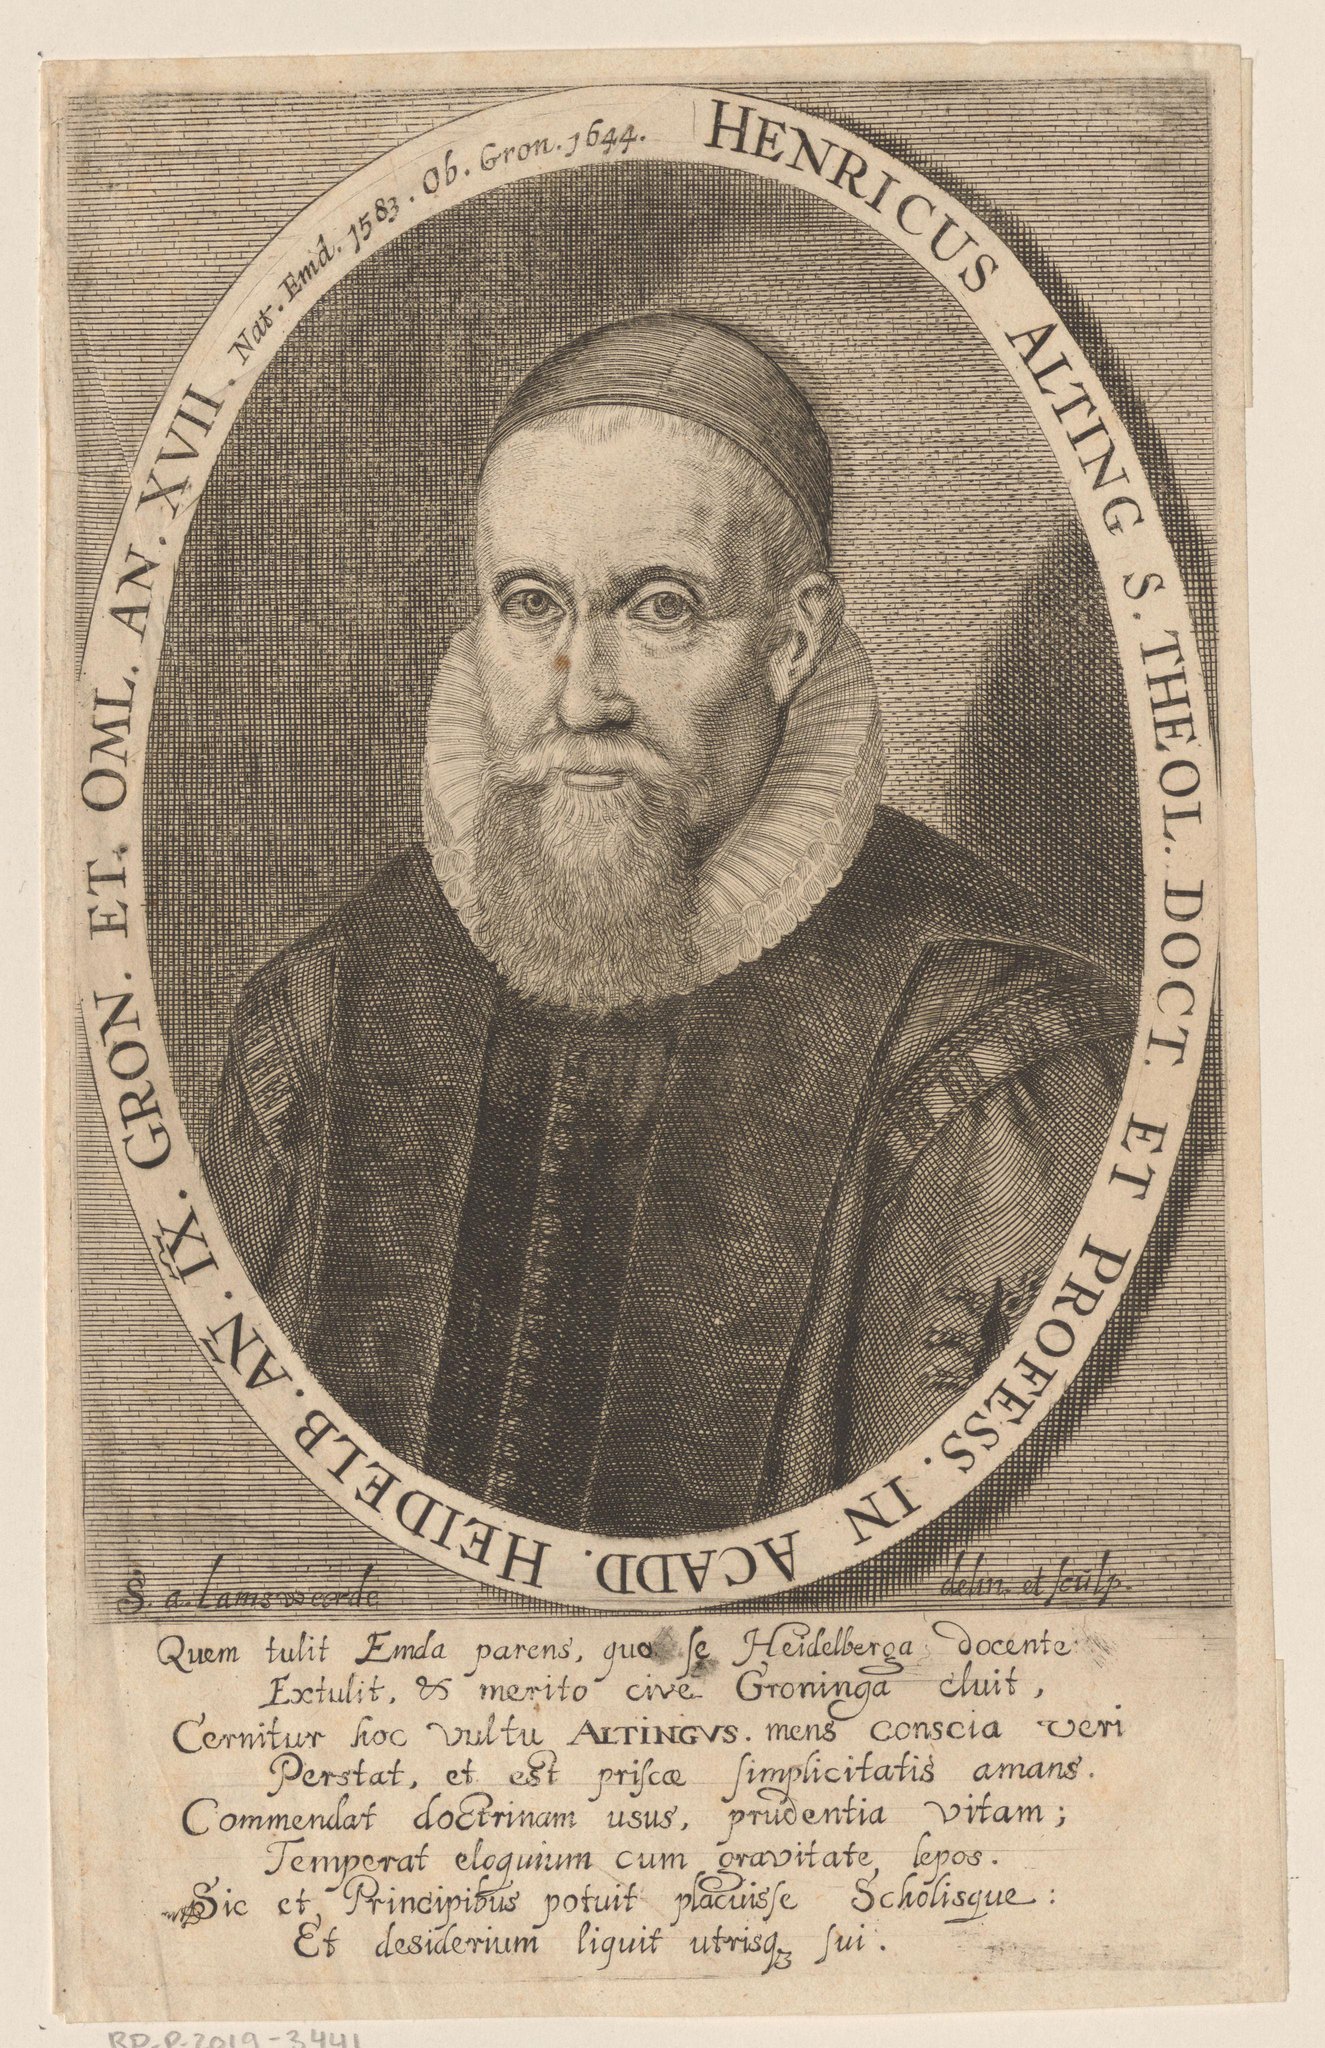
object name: print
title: Portret van Hendrik Alting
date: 1654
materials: paper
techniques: engraving, etching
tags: theologian, historical persons, professor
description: Prent uit: Effigies & vitae professorum academiae Groningae & omlandiae. Groningen: Hindrick Lussinck en Jan Claessen, 1654.